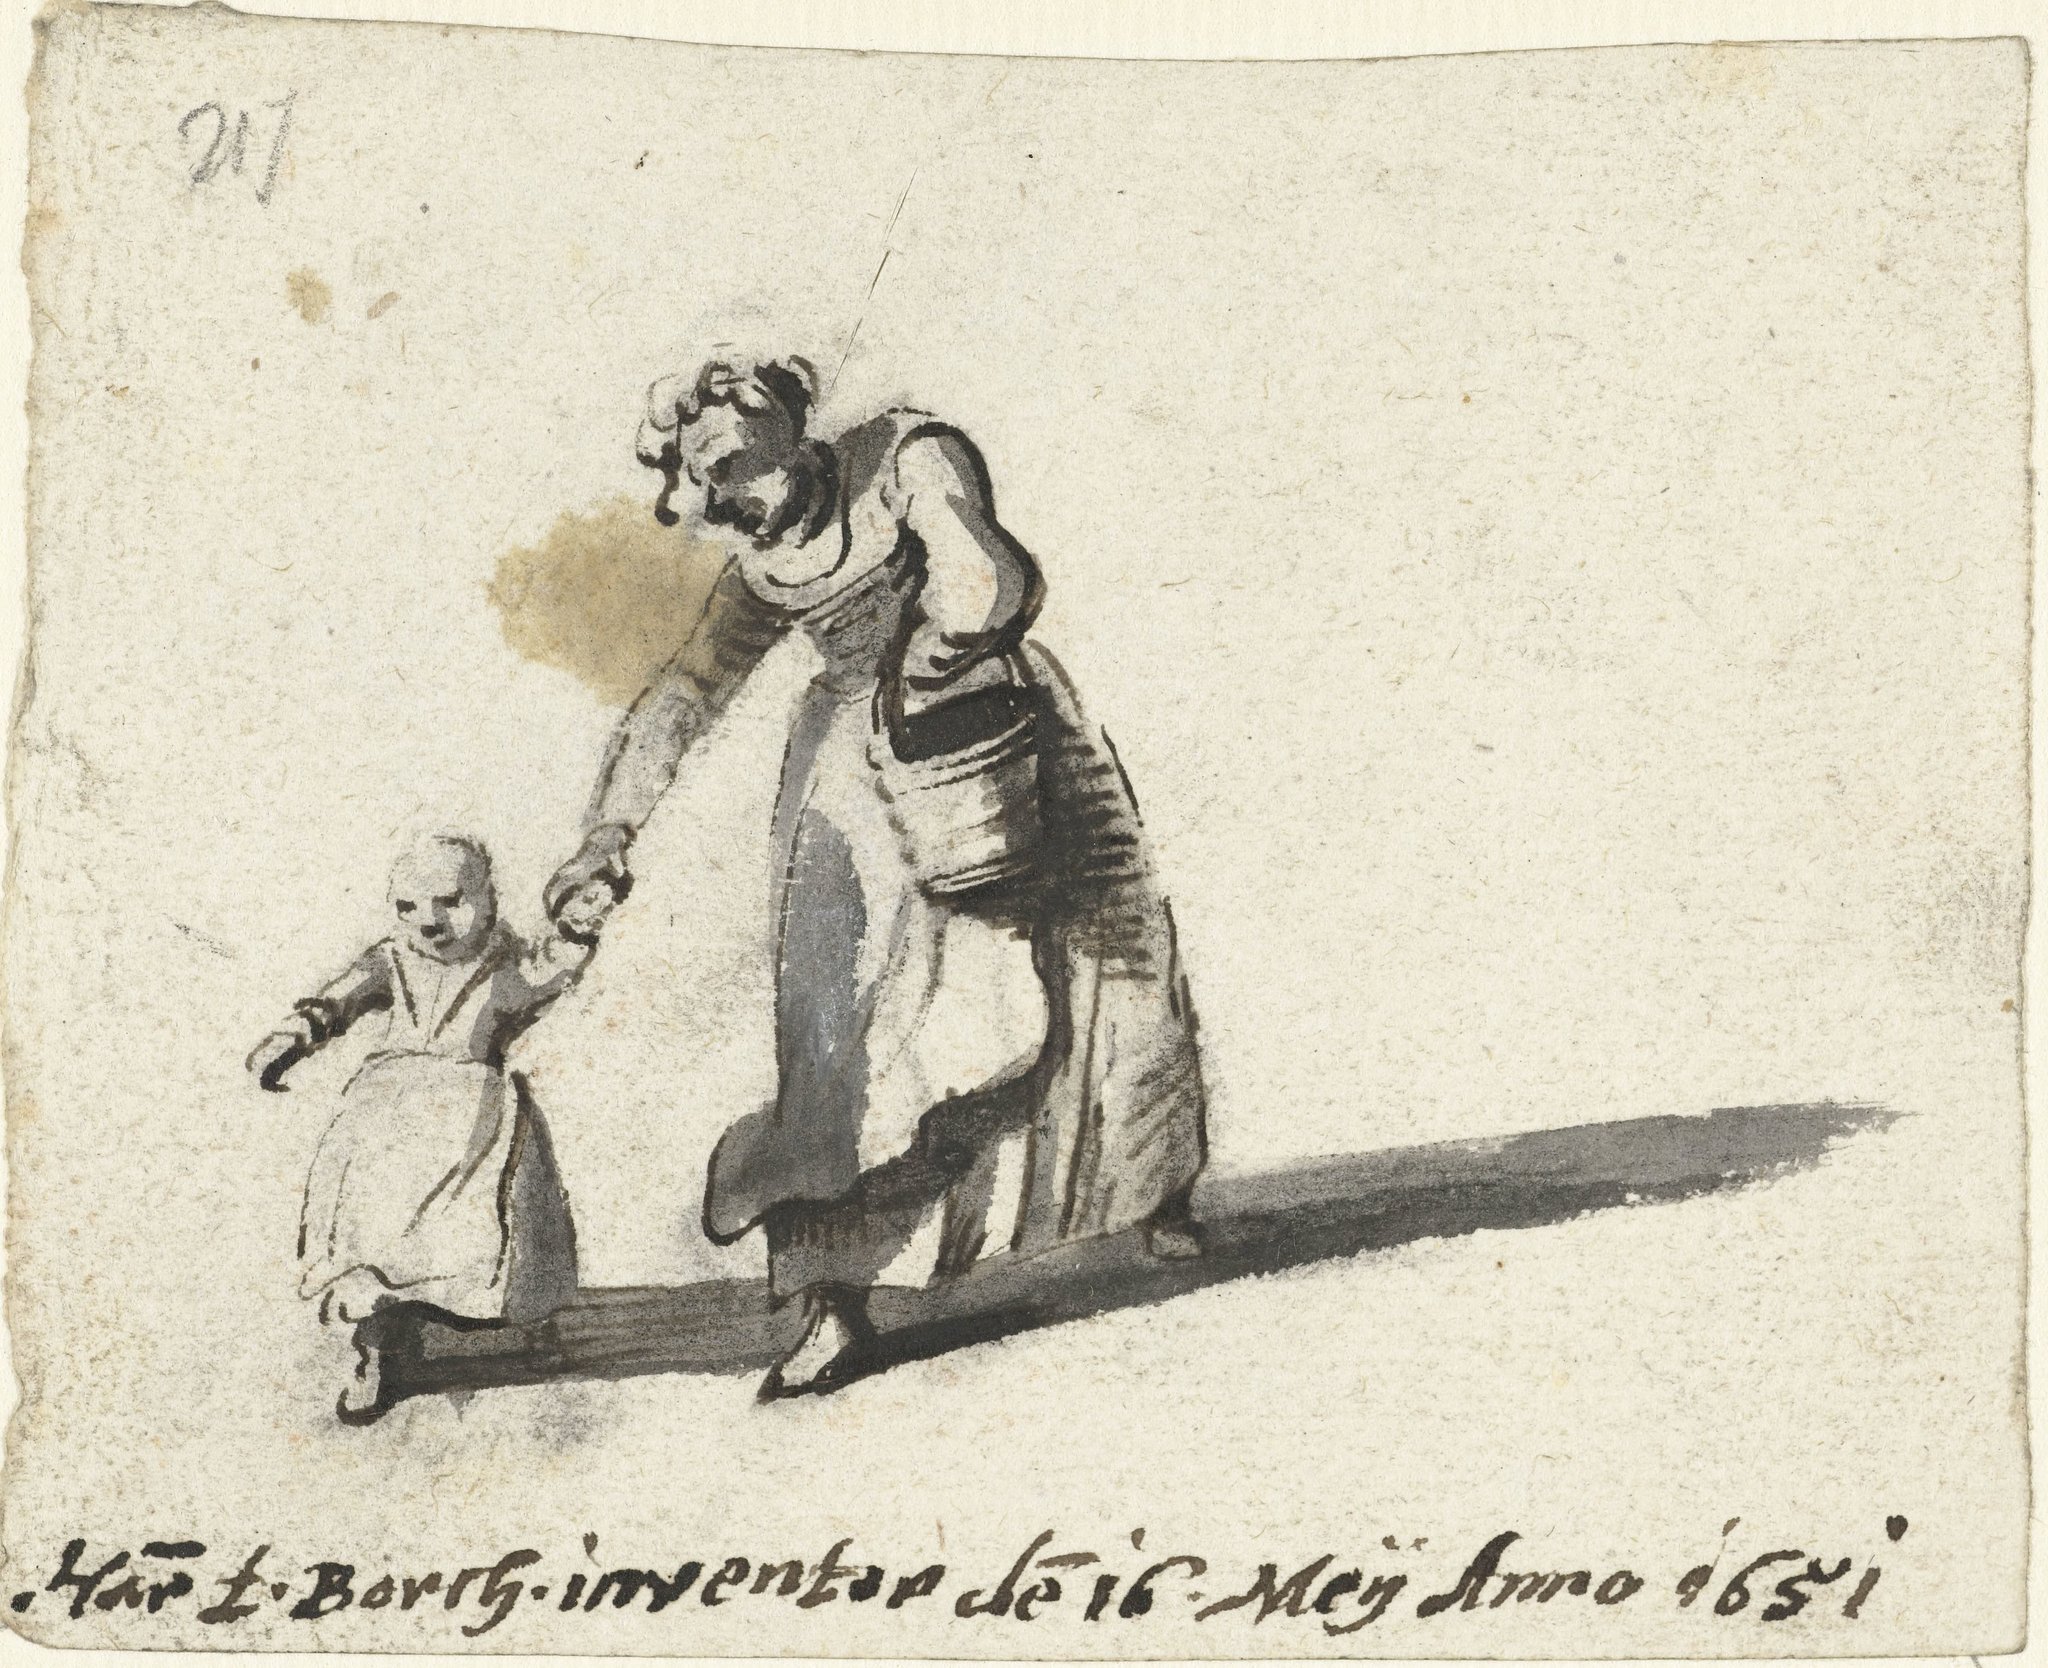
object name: drawing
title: Vrouw bukkend om de hand van een kind te pakken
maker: harmen ter borch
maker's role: draughtsman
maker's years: 1638-1677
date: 1651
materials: chalk, ink, paper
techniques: brush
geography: zwolle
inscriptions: annotation: ‘Har[men] t.Borch. inventor de[n] 16.Meij Anno 1651’